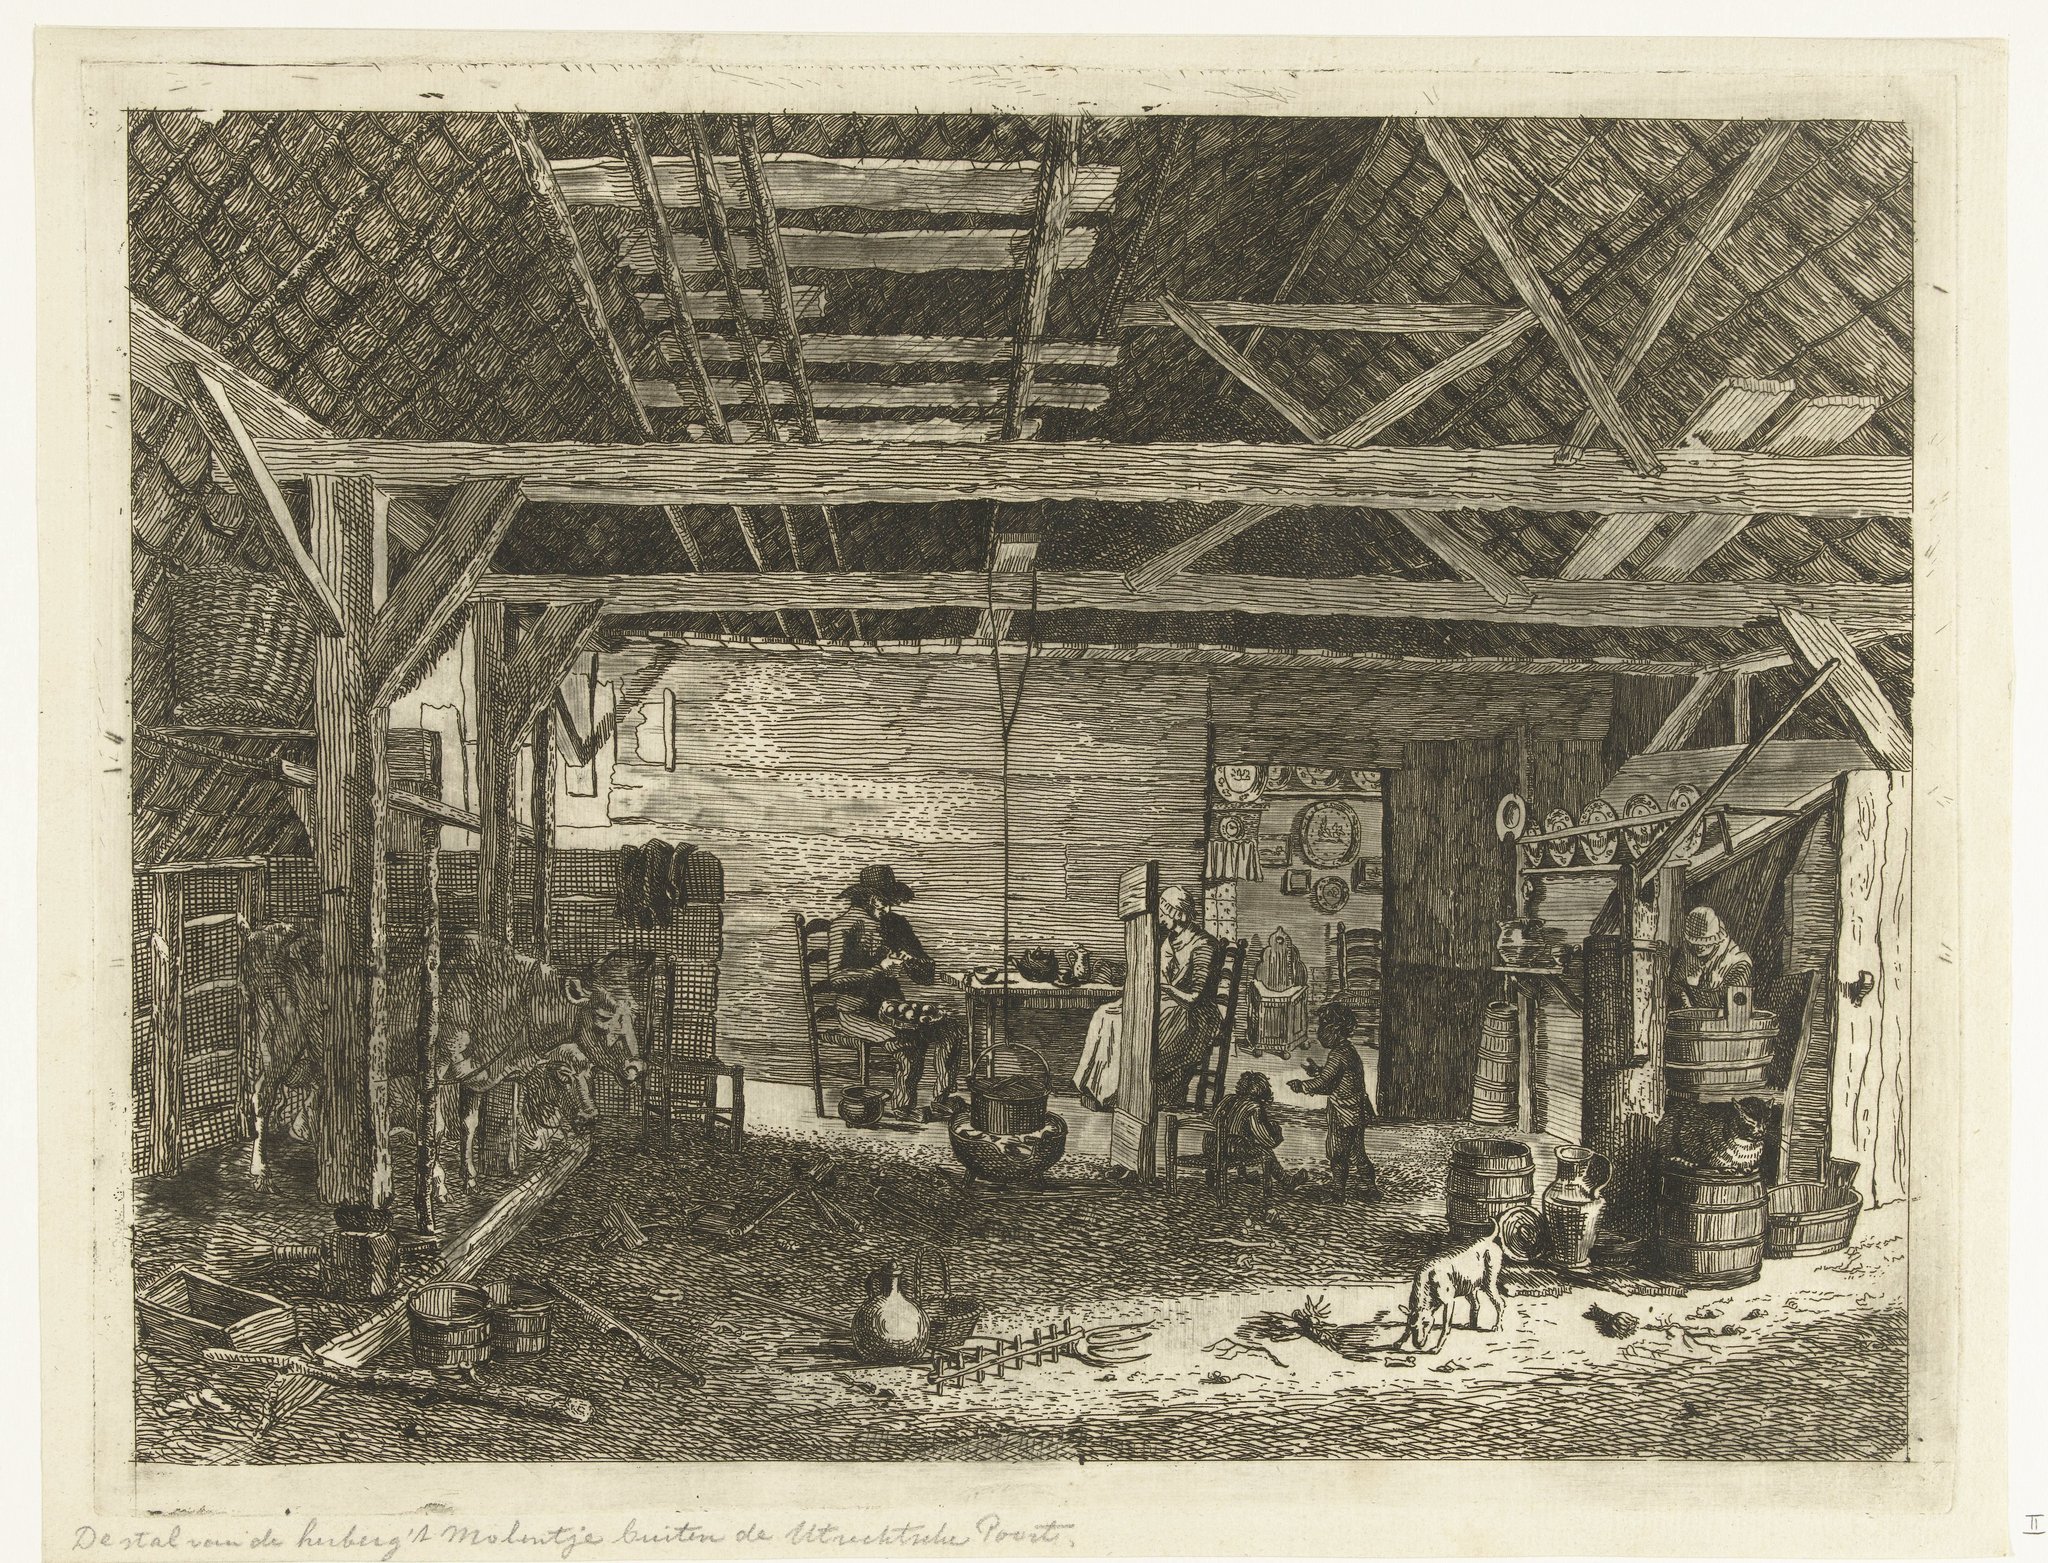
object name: print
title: De stal van de herberg 't Molentje buiten de Utrechtse Poort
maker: anthonie van den bos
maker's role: draughtsman, print maker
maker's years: 1763-1838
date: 1778-1838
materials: paper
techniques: etching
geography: netherlands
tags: barn, farmers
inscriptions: collector's mark: Lugt 2228